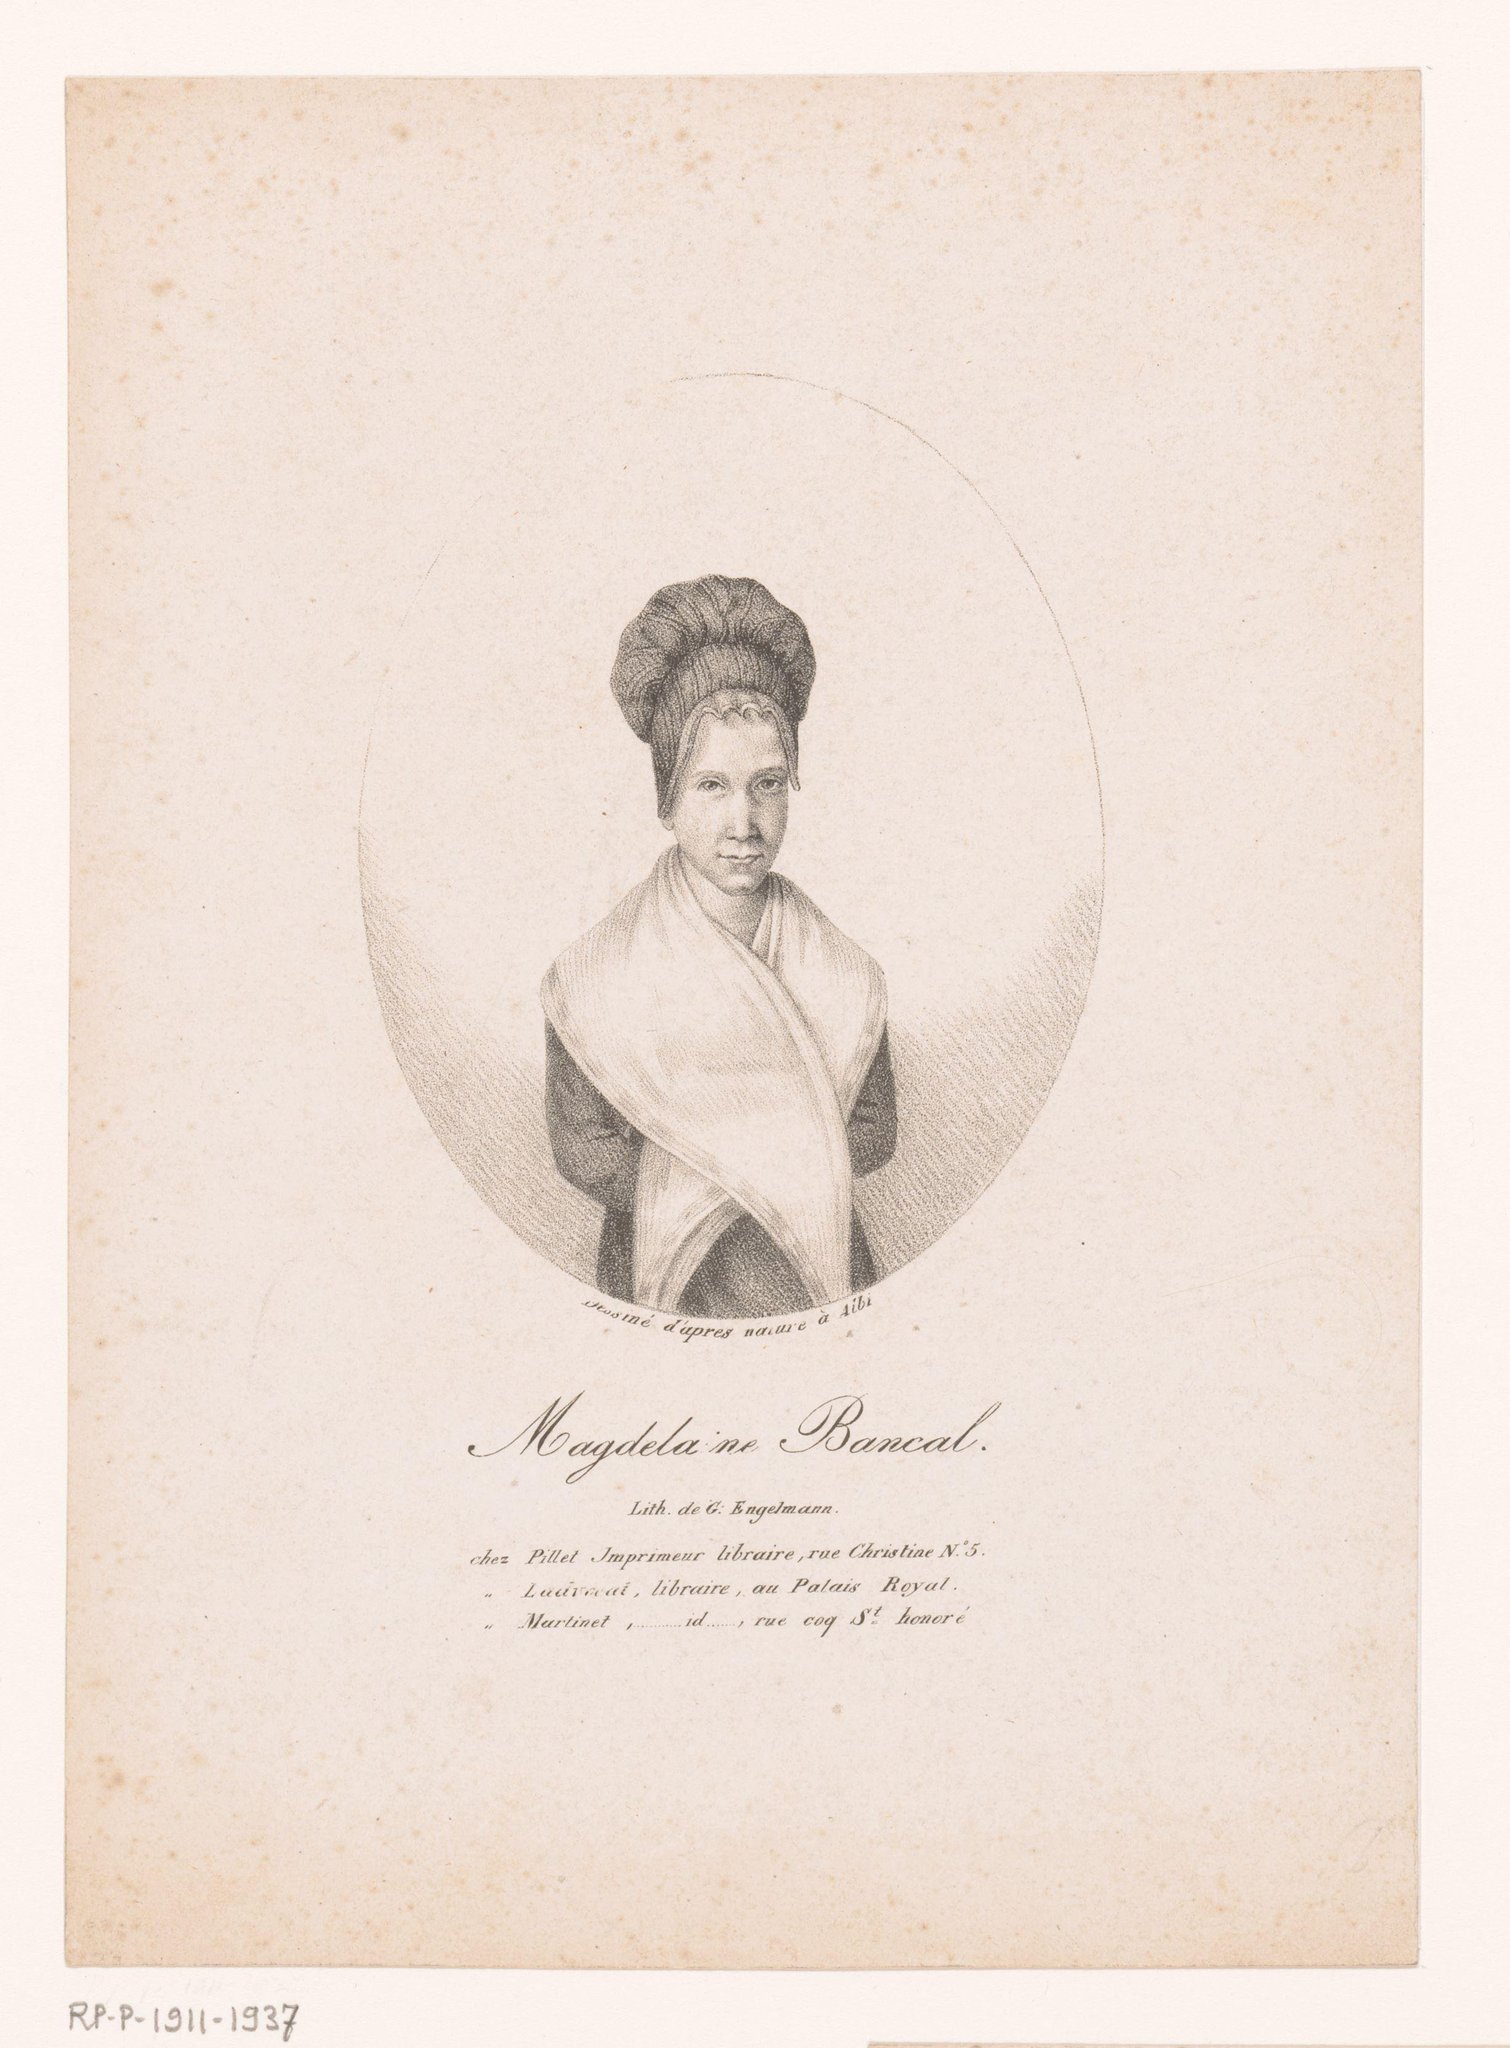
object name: print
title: Betrokkenen bij de rechtszaak over de moord op Fualdès in 1818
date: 1818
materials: paper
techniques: lithograph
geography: paris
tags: historical persons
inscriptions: collector's mark: Lugt 2228a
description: Antoine Bernardin Fualdès werd op 19 maart 1817 vermoord te Rodez. Deze moord leidde in 1818 tot een rechtszaak die de geschiedenis in zou gaan als een van de beroemdste justitiële affaires van de negentiende eeuw (de 'Affaire Fualdès').